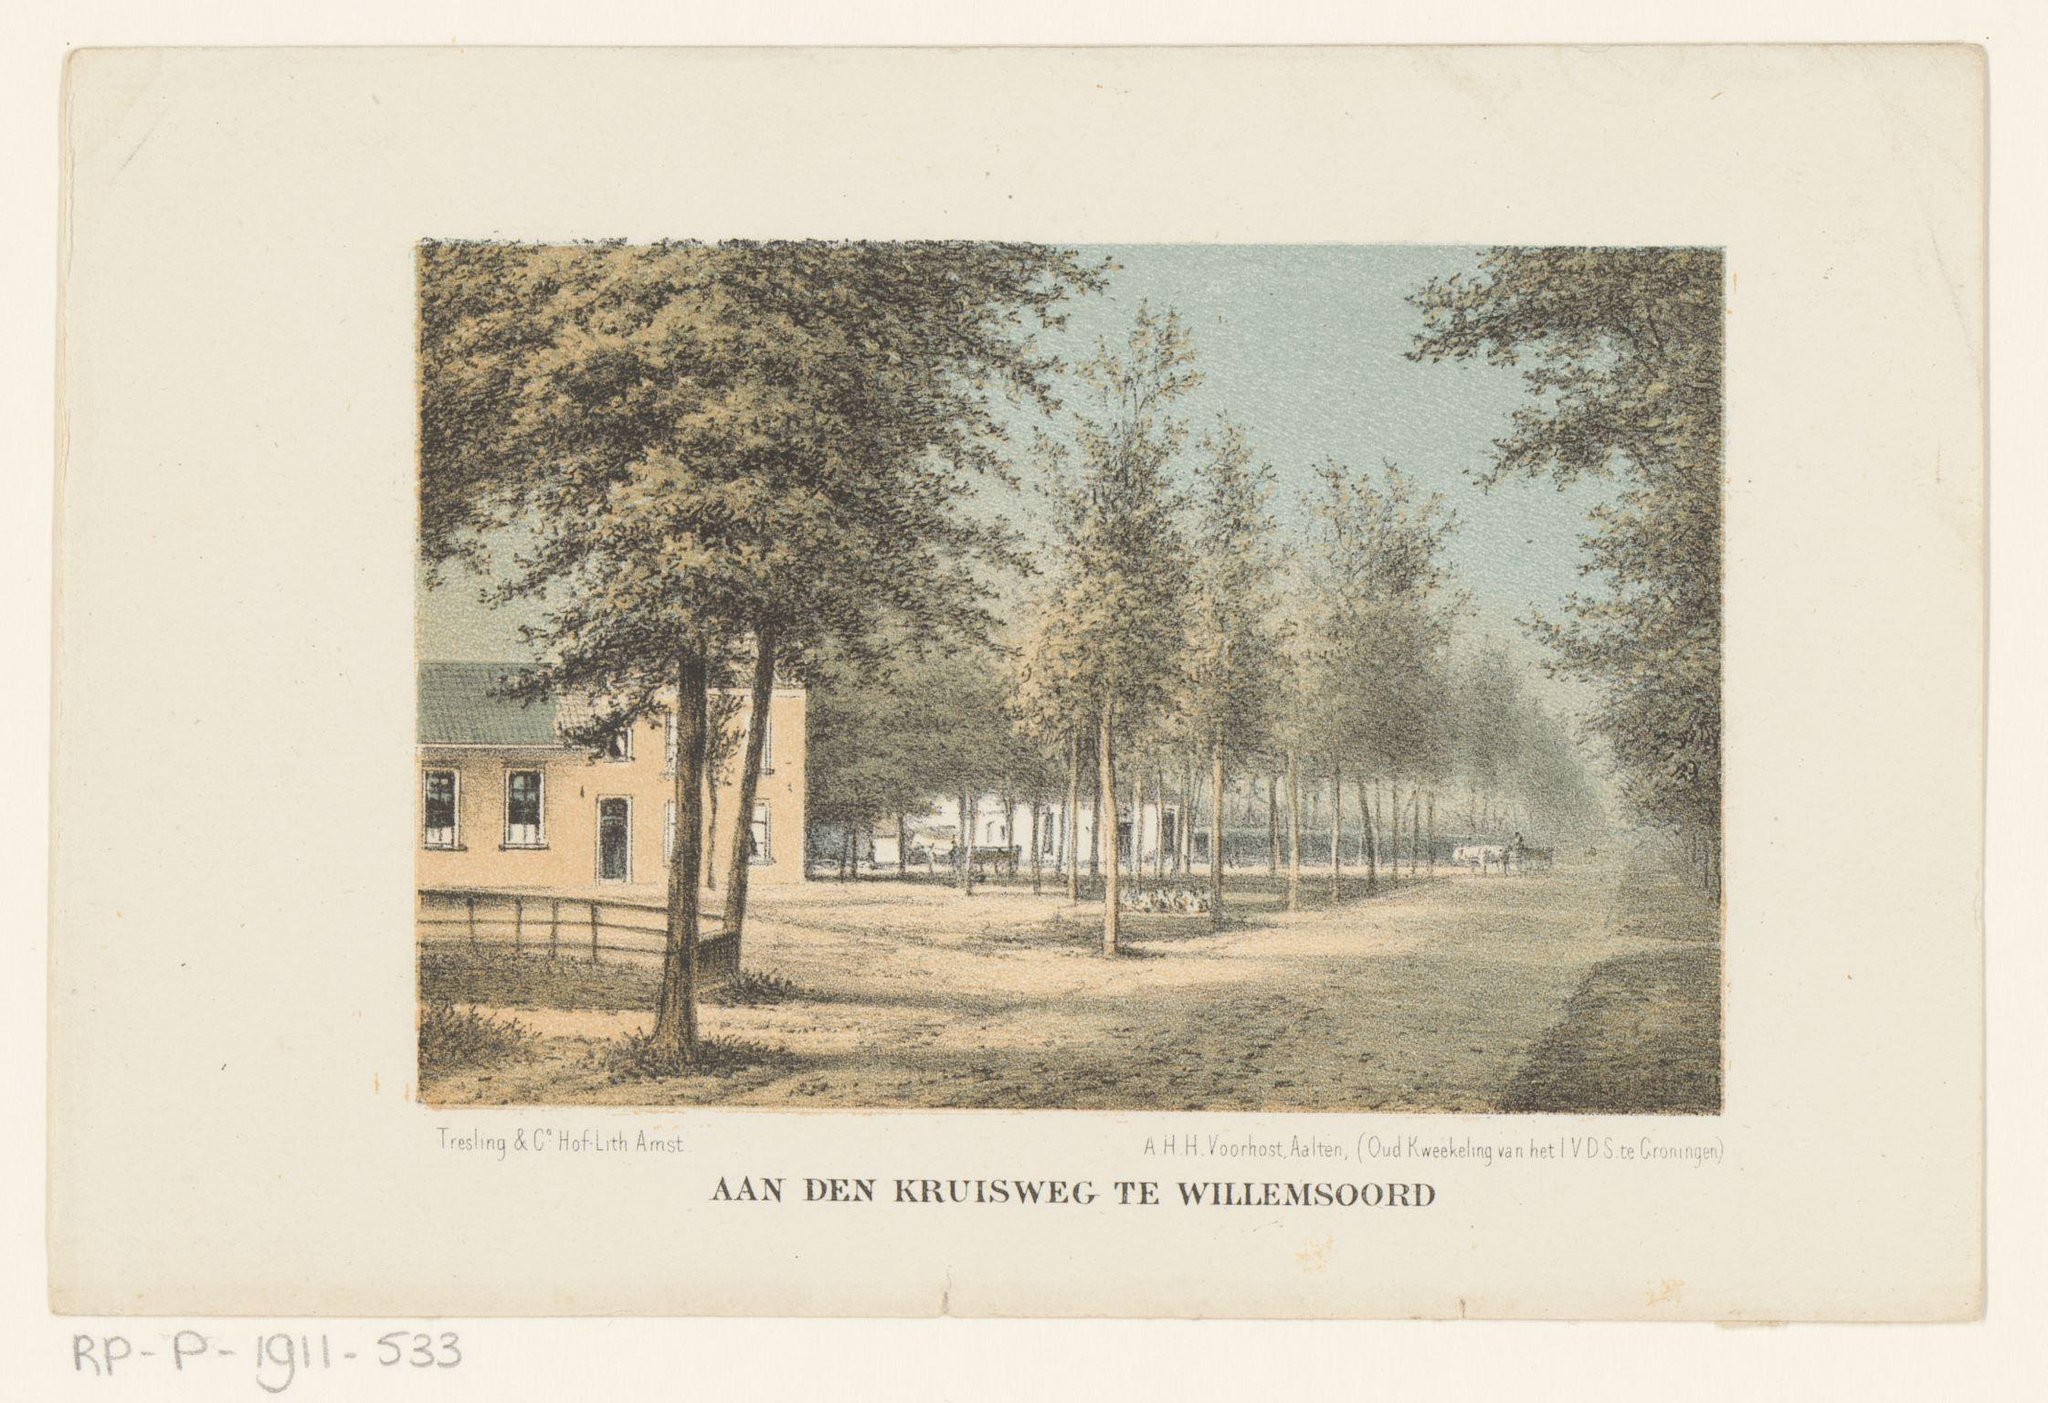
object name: book illustration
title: Gezicht te Willemsoord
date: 1871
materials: paper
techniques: tone lithography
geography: amsterdam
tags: scholastic education, tuition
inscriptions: collector's mark: Lugt 2228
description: Prent uit: S.n. Jaarboekje der maatschappij van weldadigheid voor 1872. Amsterdam: Centen, D.B., 1871.